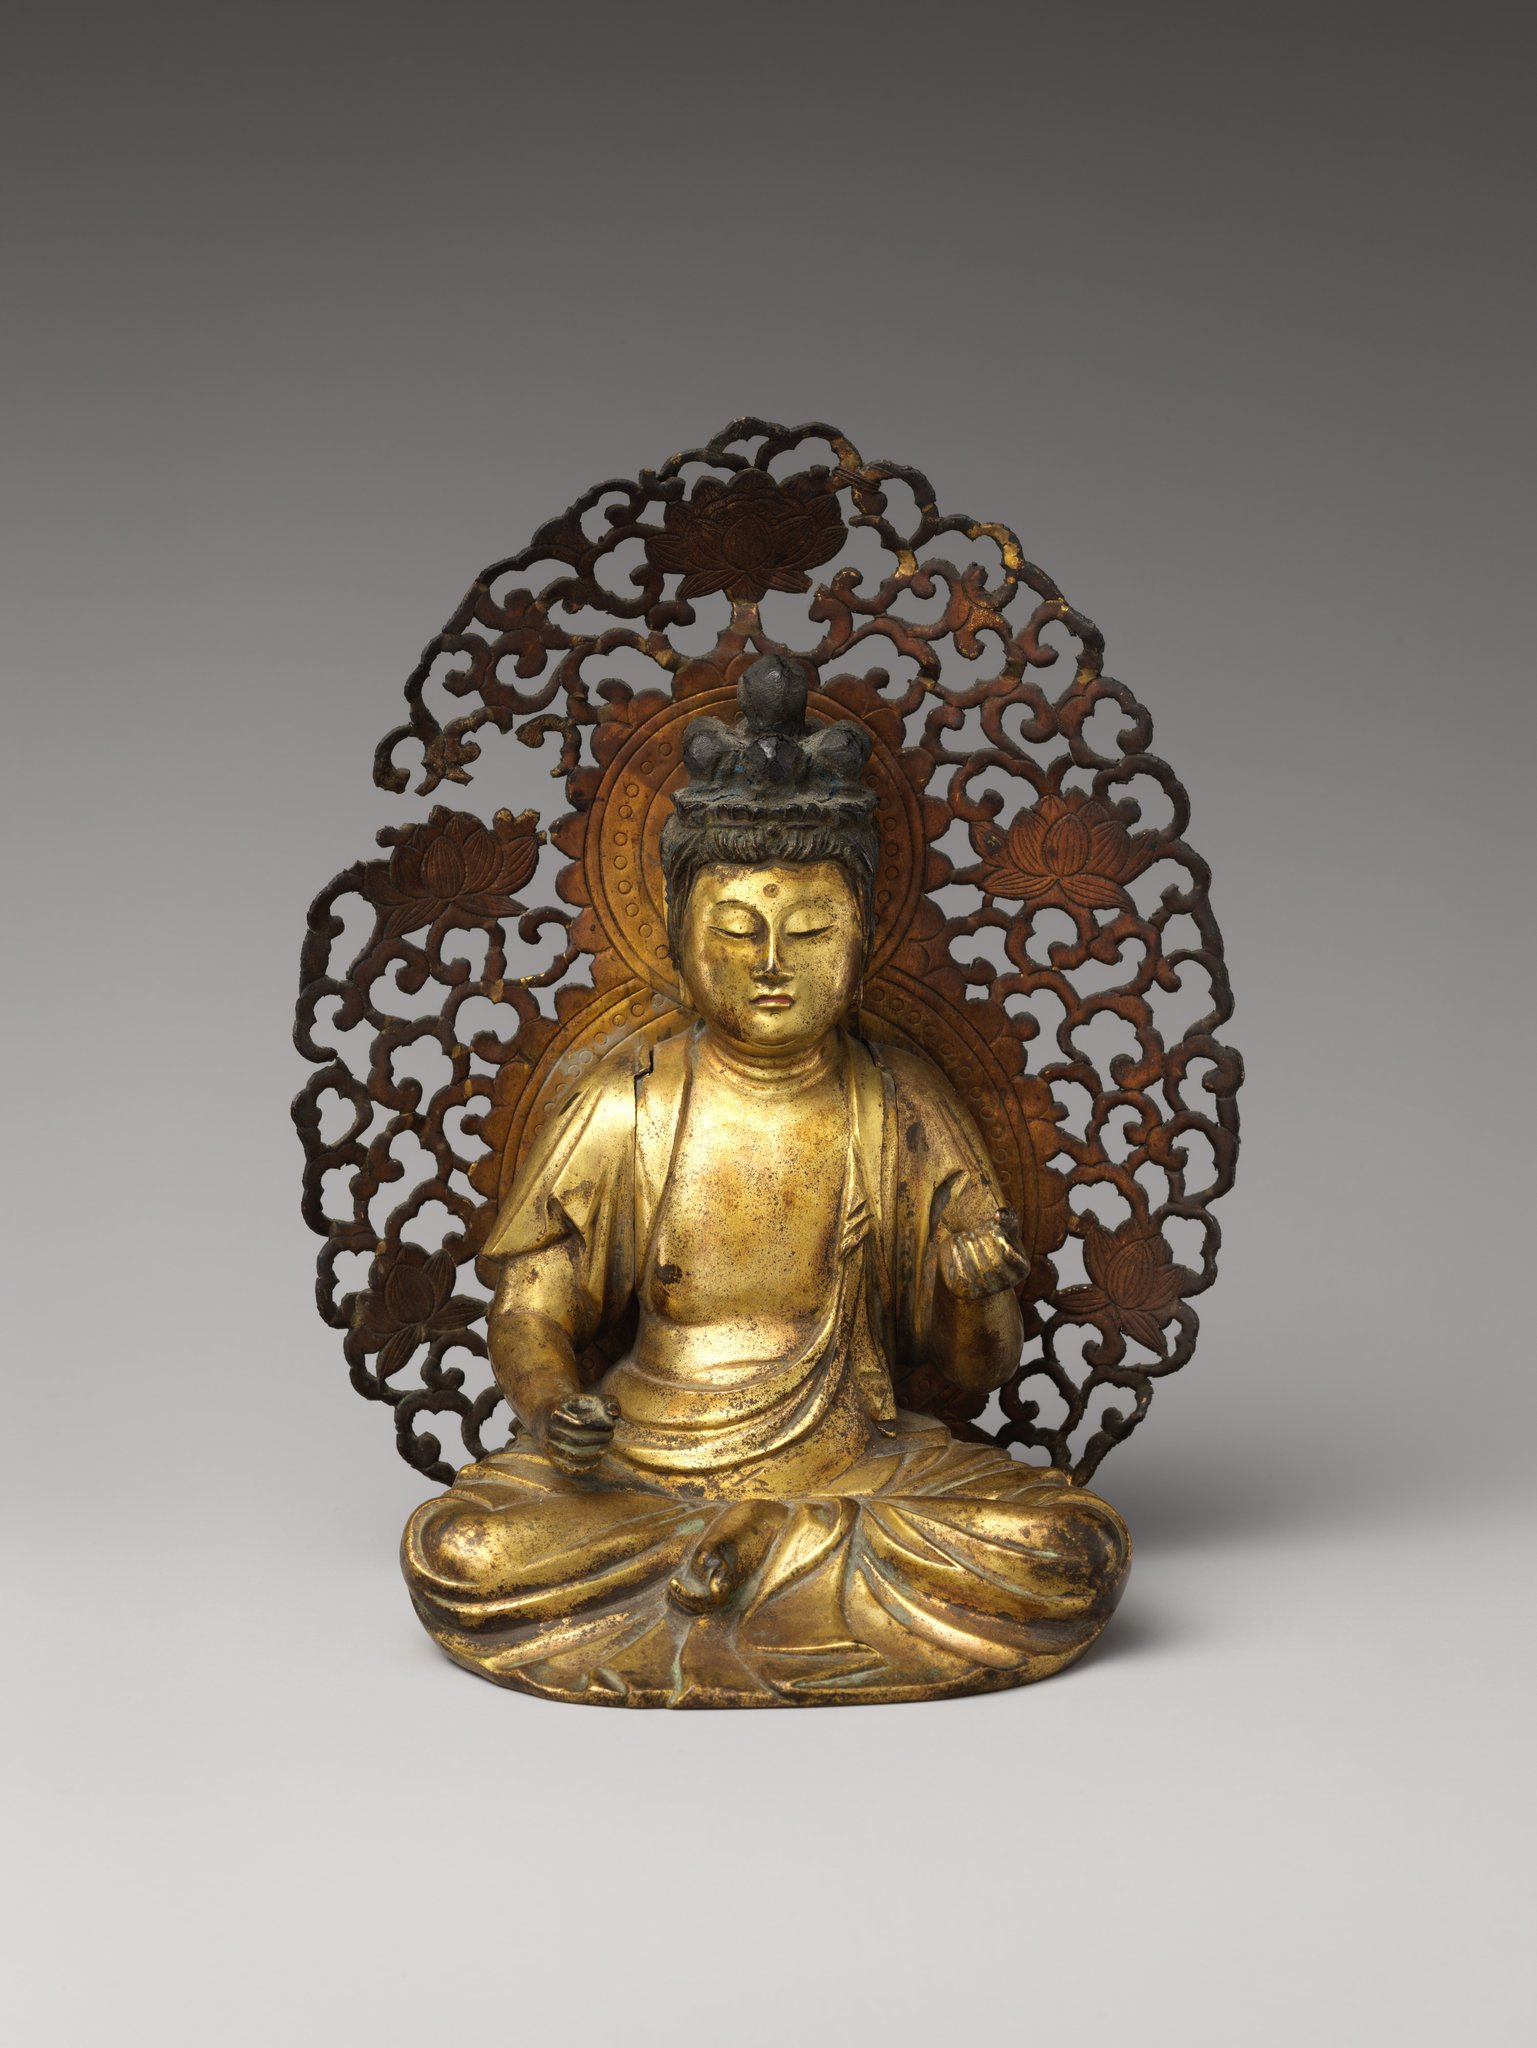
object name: figure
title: The Bodhisattva Monju (Manjushri) with Eight Topknots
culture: japanese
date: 1267-1300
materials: gilt bronze